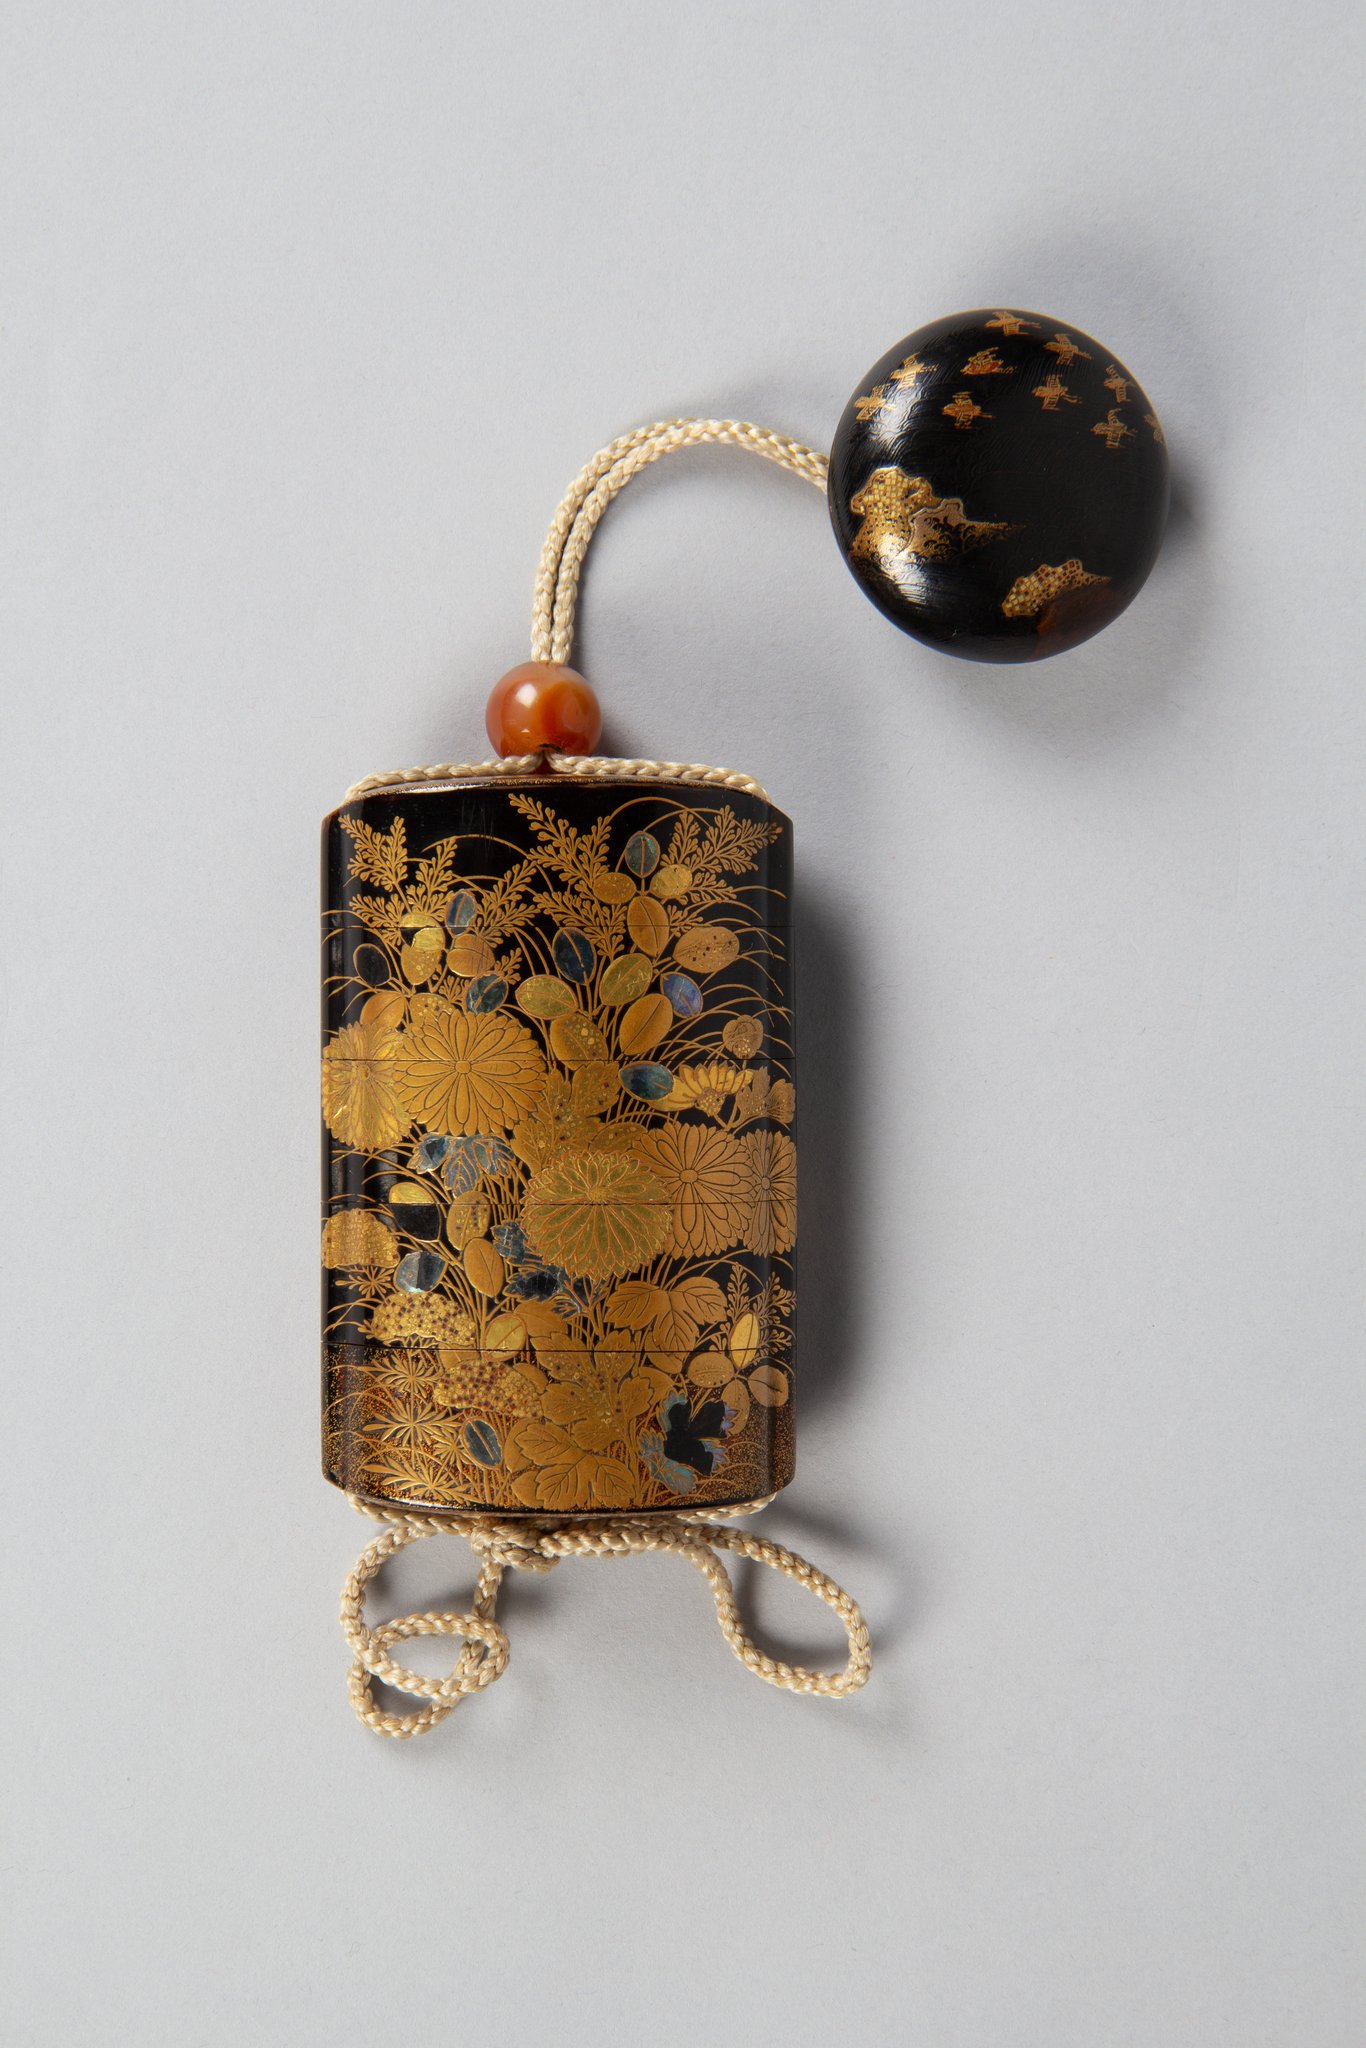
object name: inrō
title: Case (Inrō) with Design of Flowering Hagi, Chrysanthemum and Autumn Grasses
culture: japanese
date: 1701-1900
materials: gold, gold foil, lacquer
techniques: fundame, hiramakie, roiro, maki-e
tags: flowers